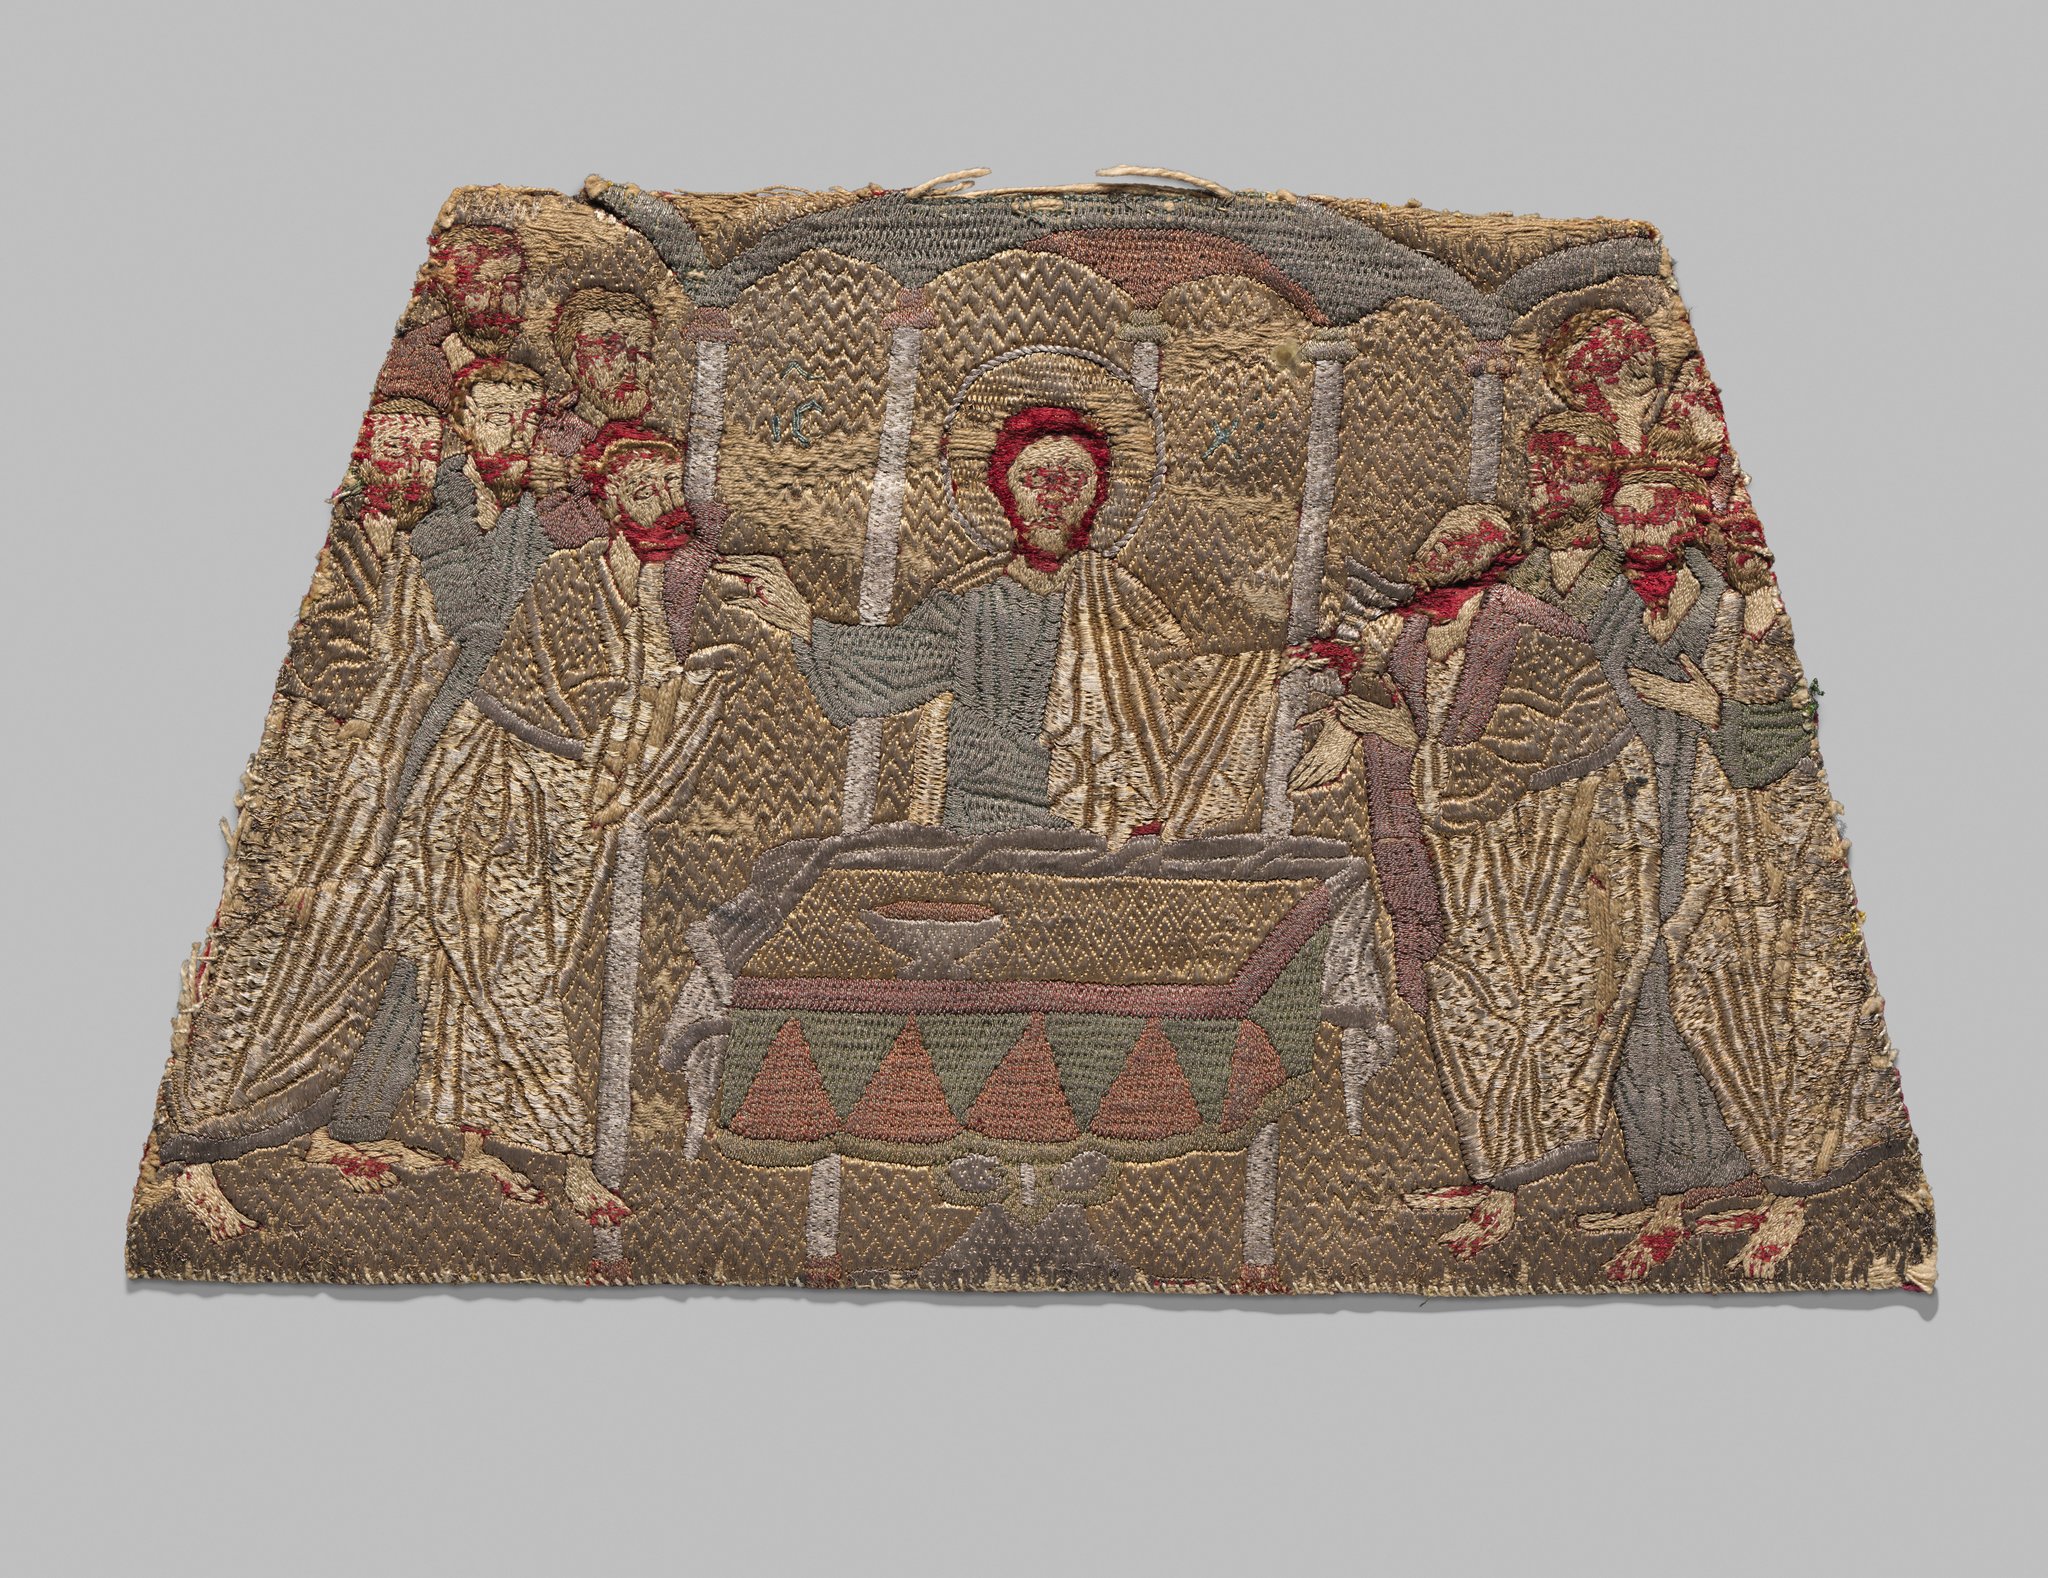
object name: cuff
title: Liturgical Cuff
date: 1501-1600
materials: cotton, metal thread, silk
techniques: embroidery, weave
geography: bulgaria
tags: altars,christ